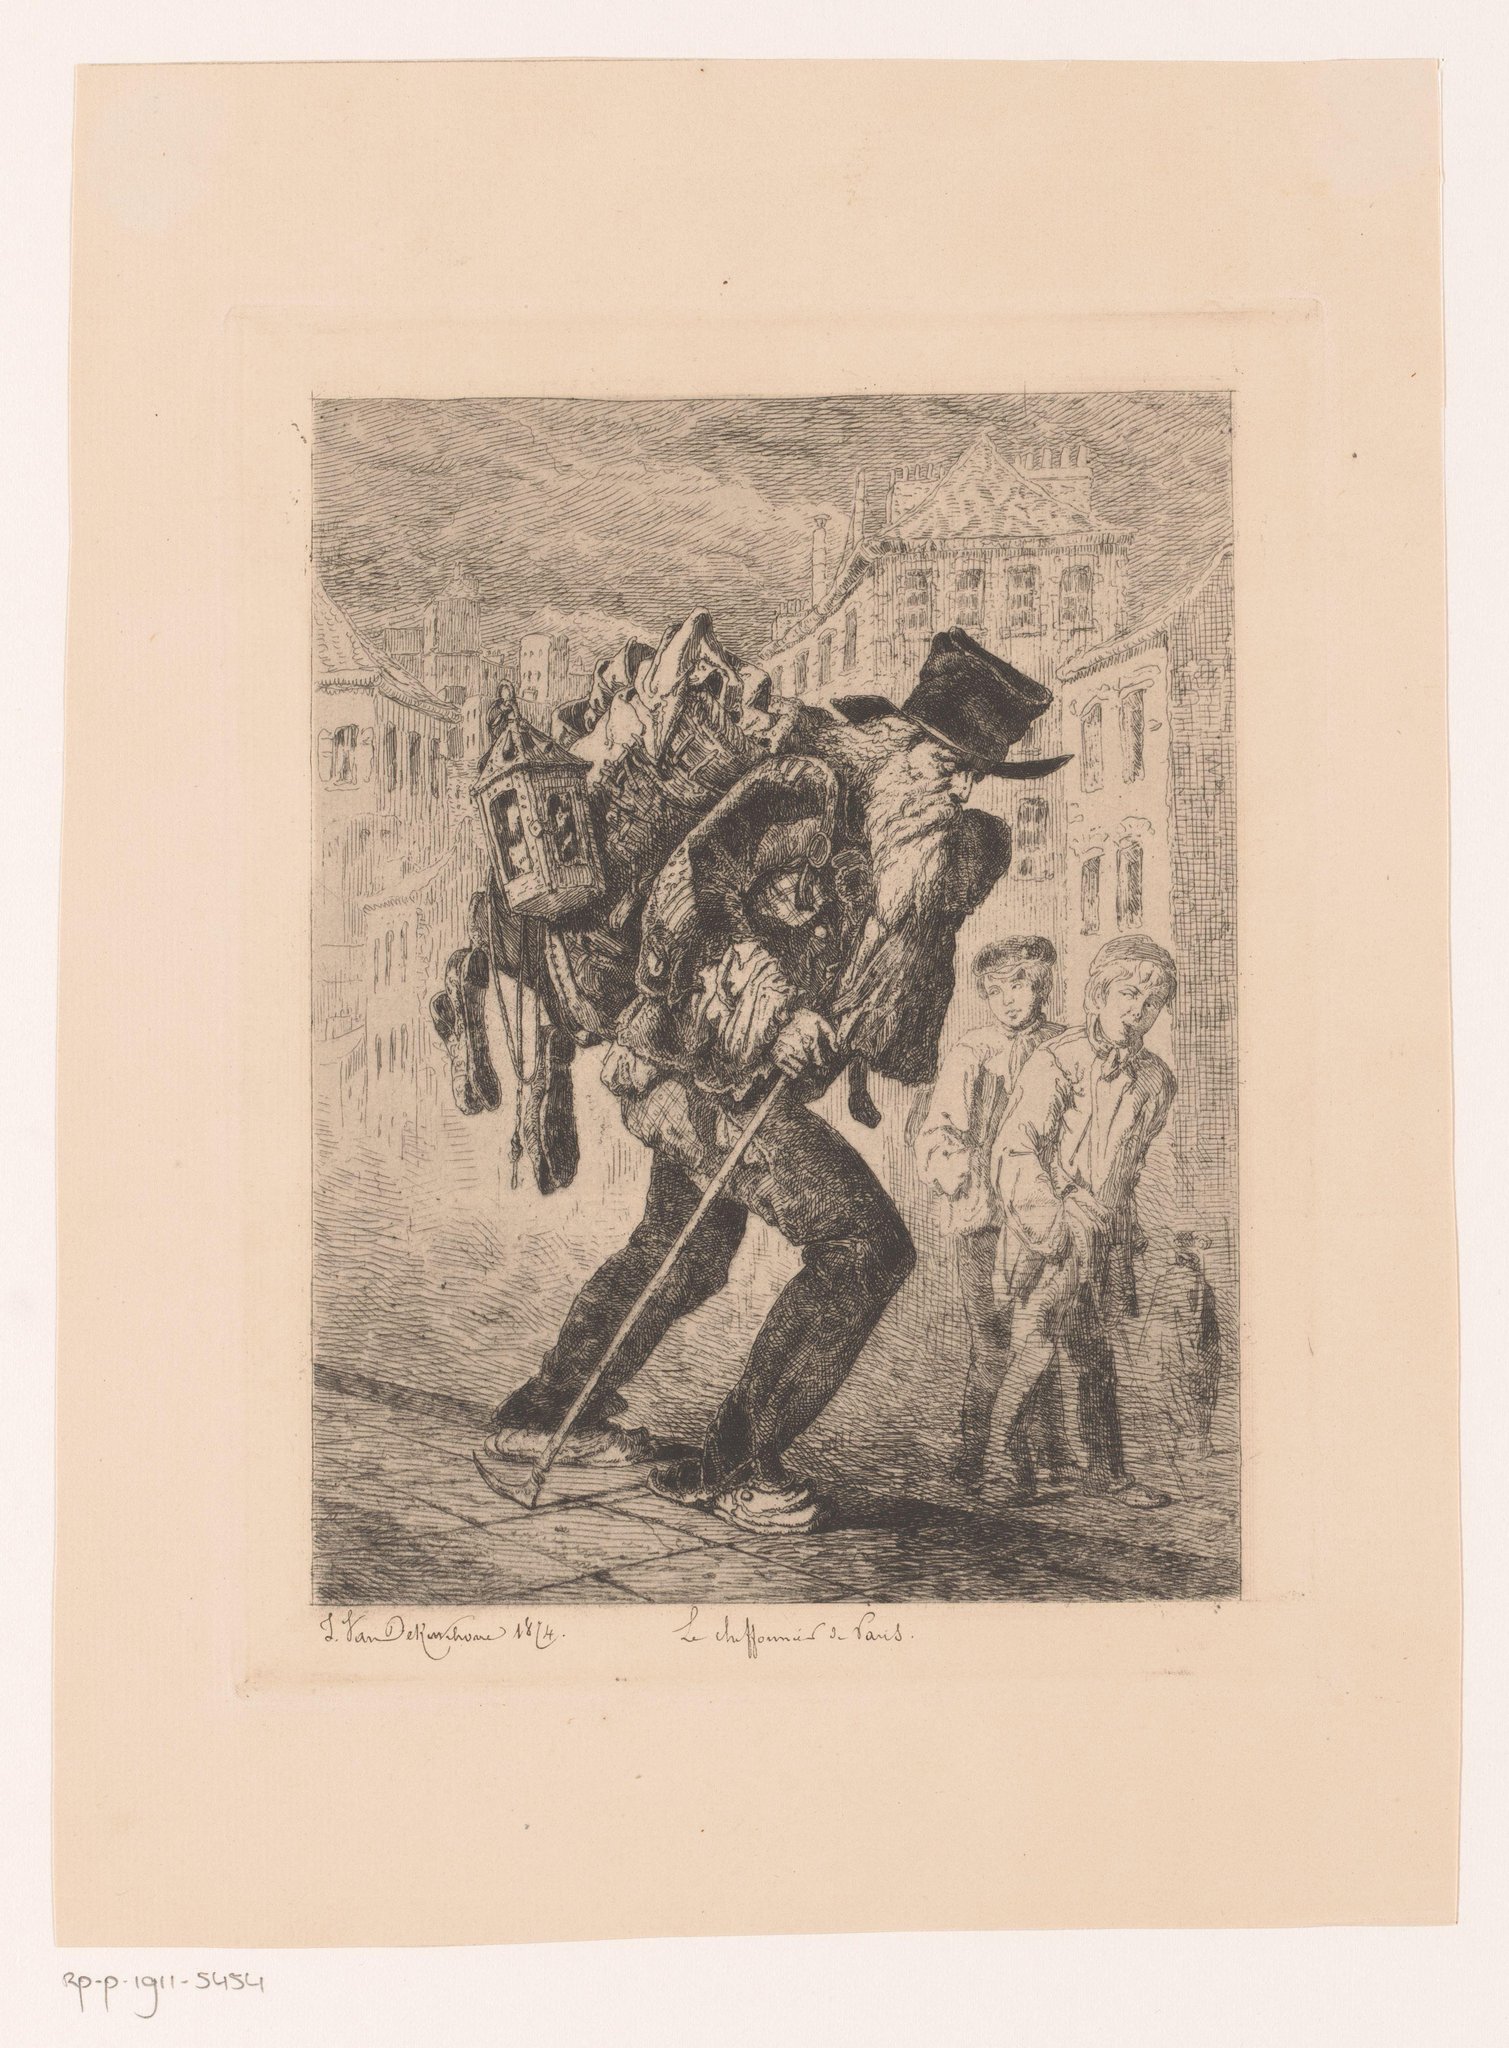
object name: print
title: Le chiffonnier de Paris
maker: jan van de kerkhove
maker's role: print maker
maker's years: 1822-1881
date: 1874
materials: paper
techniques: drypoint, etching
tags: street-trader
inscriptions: collector's mark: Lugt 2228